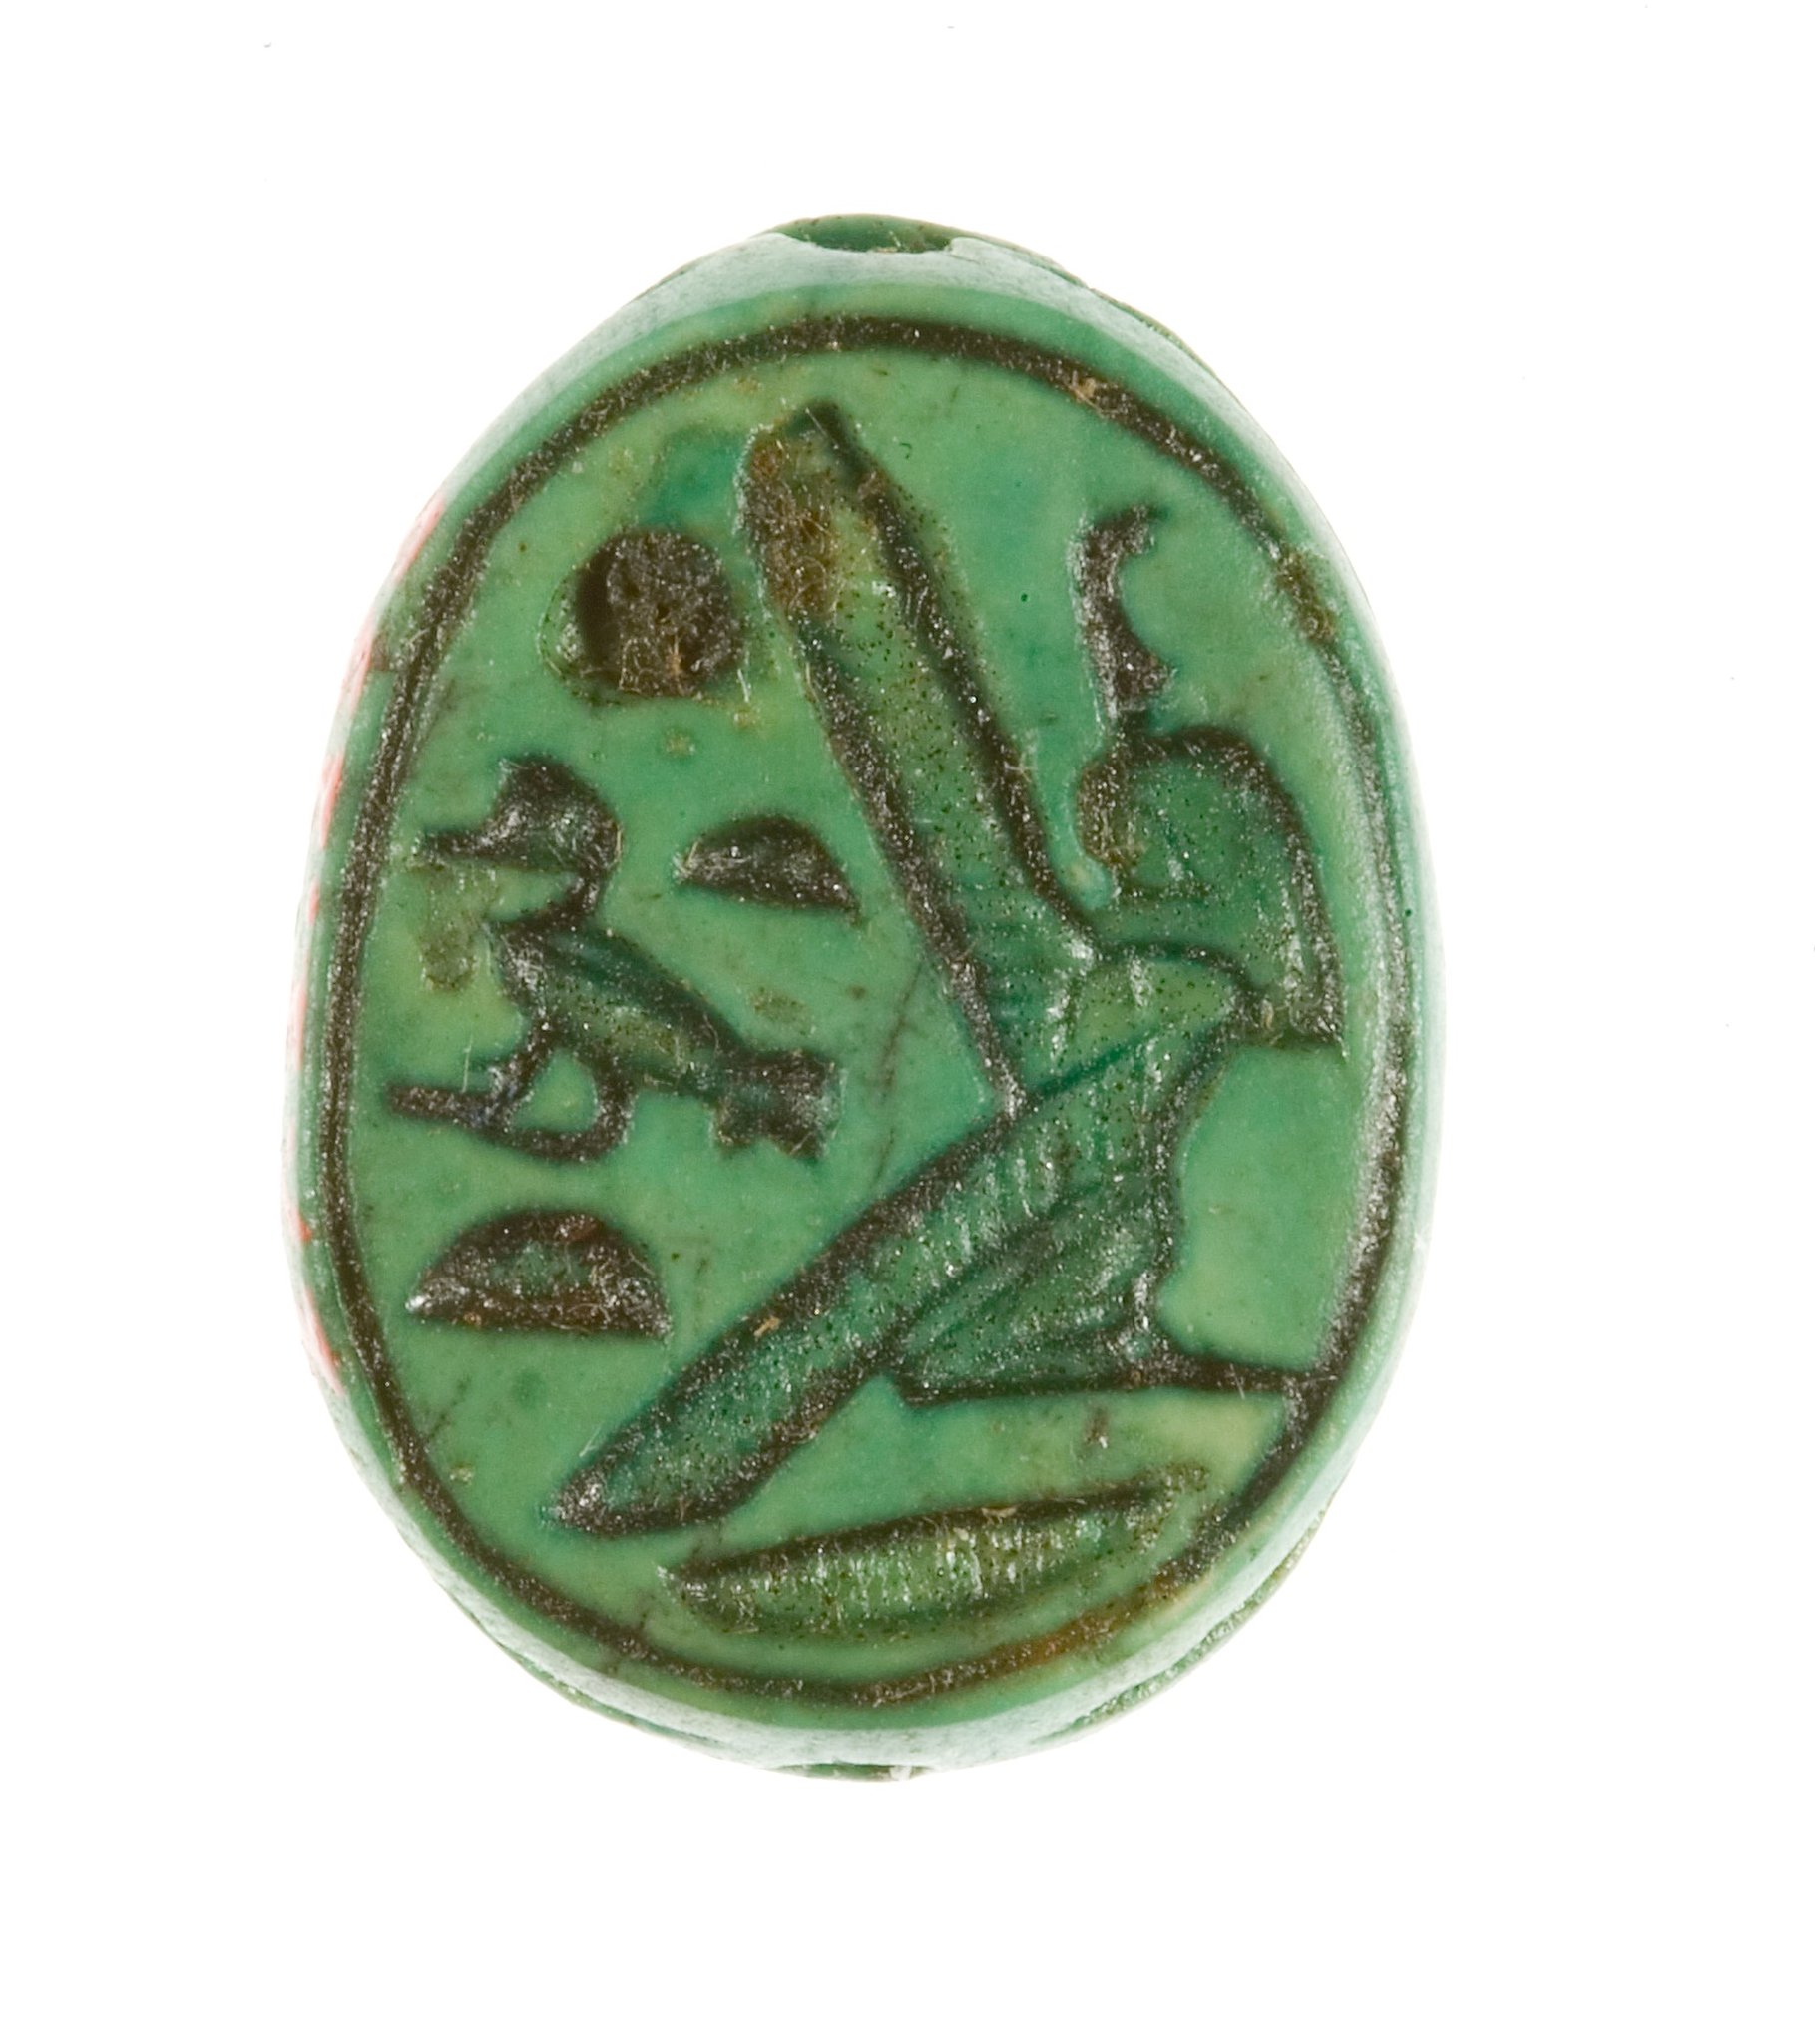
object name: scarab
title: Scarab Inscribed Daughter of Re, with Winged Maat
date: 1479-1458 BCE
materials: stone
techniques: glazing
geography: egypt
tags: hieroglyphs,scarabs